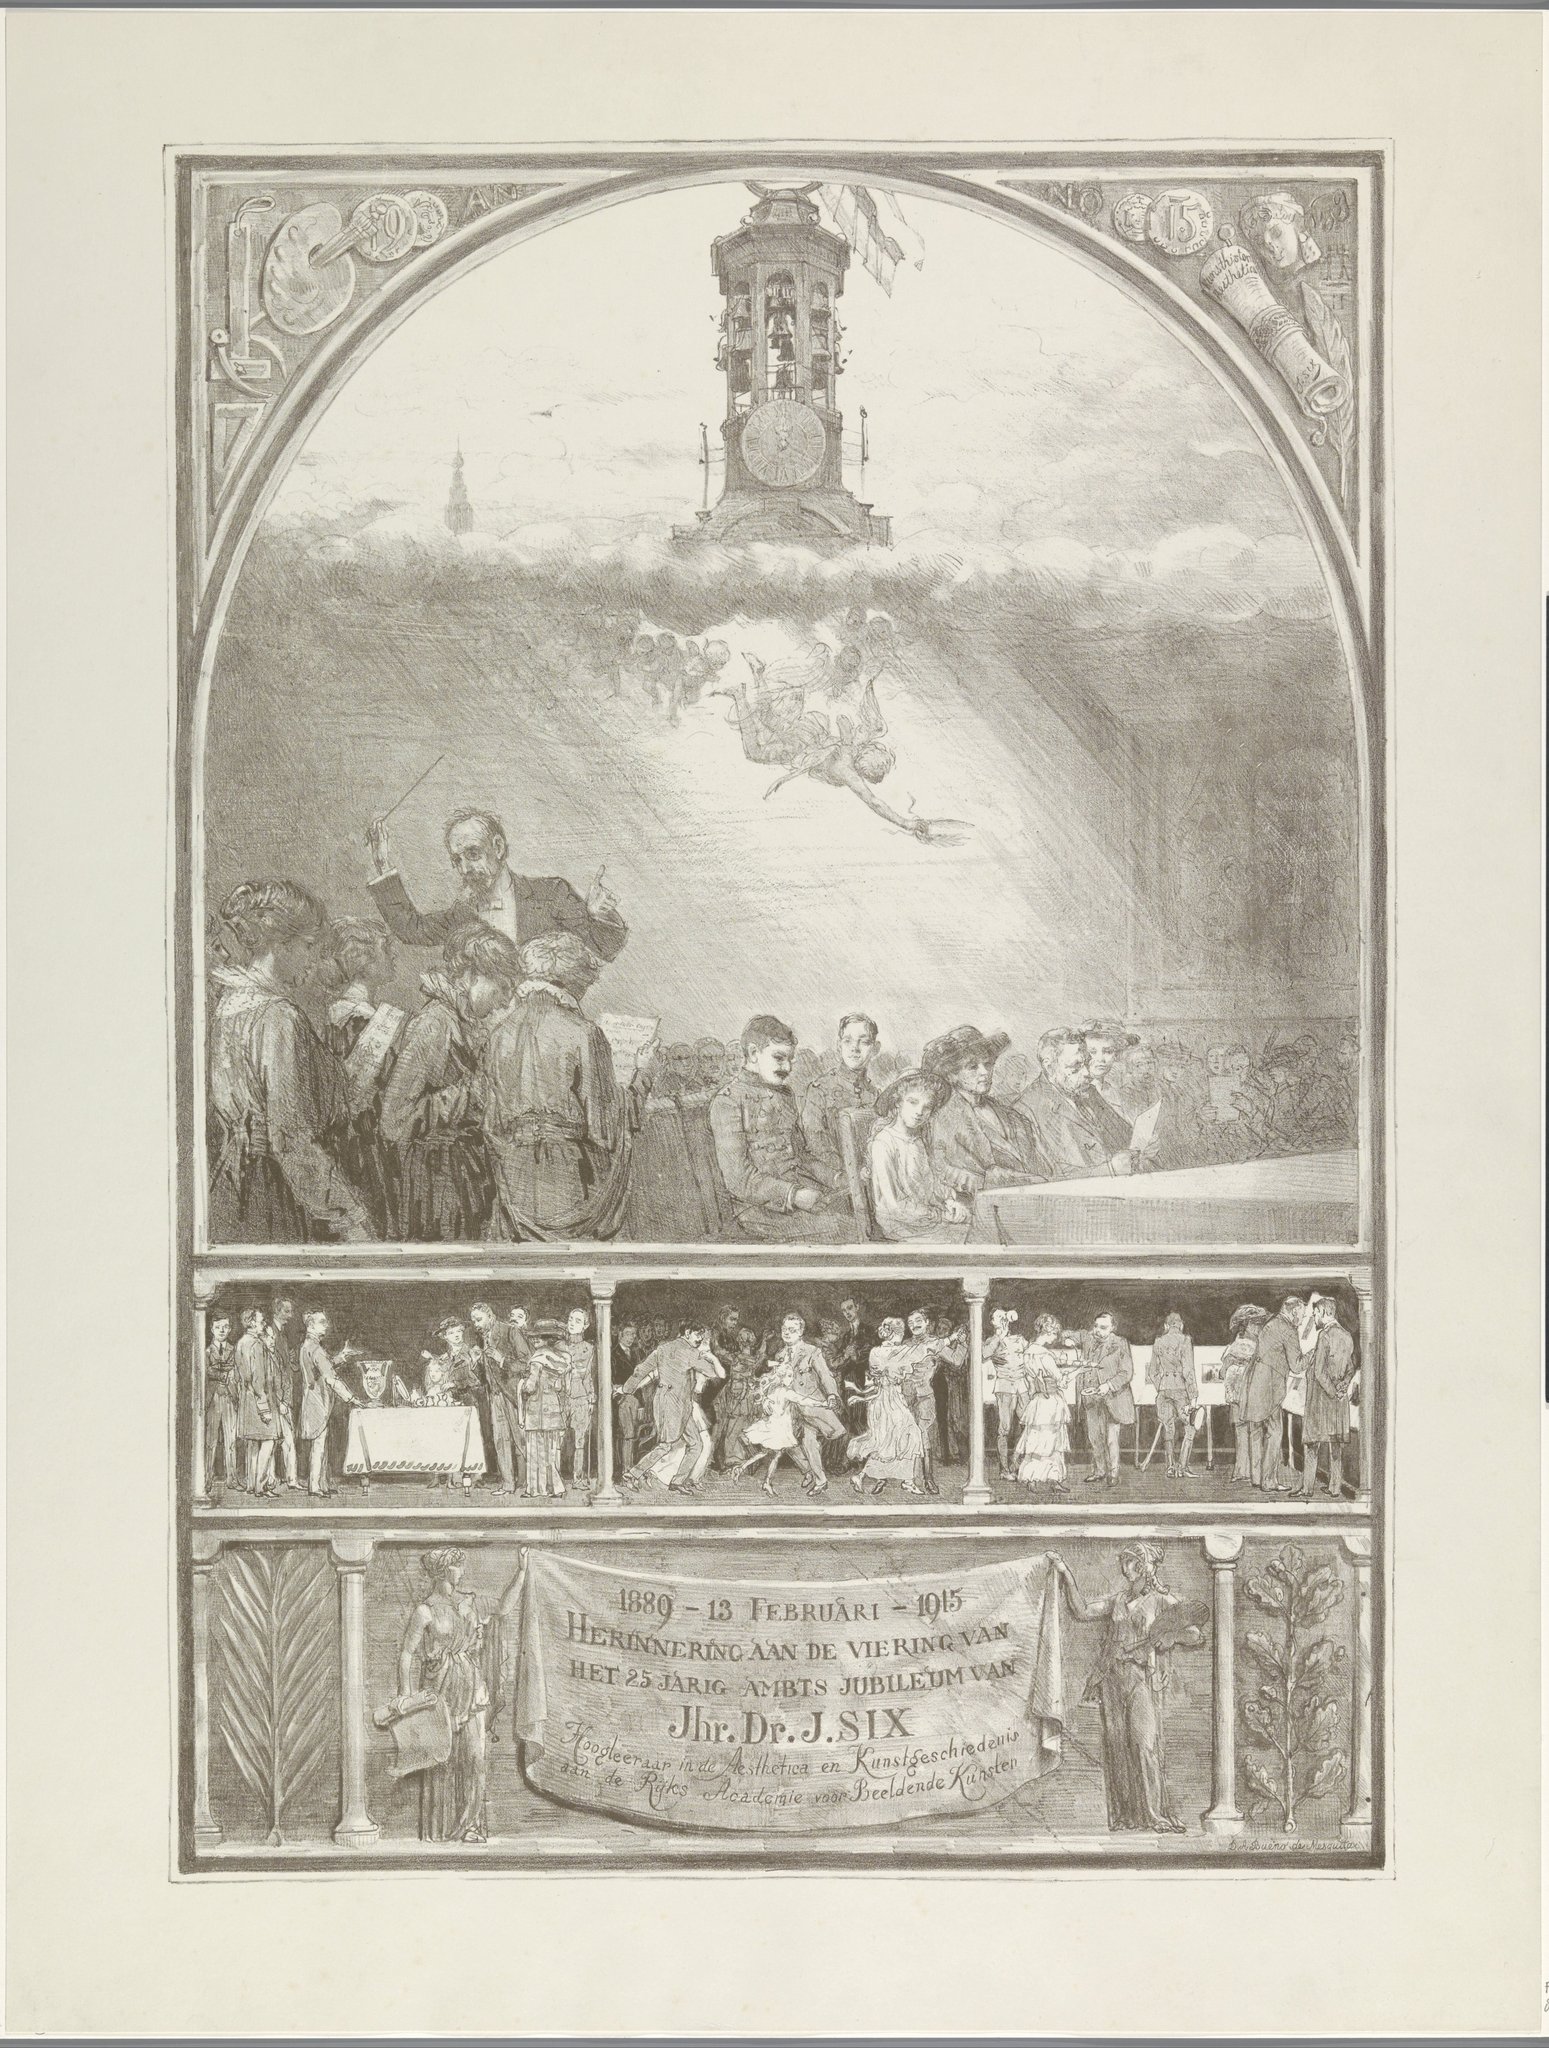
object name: print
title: 1889 - 13 Februari - 1915 / Herinnering aan de viering van het 25 jarig ambts jubileum van Jhr Dr. J. Six / Hoogleeraar in de Aesthetica en Kunstgeschiedenis aan de Rijks Academie voor Beeldende Kunsten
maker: david bueno de mesquita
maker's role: draughtsman, print maker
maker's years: 1889-1962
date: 1915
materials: paper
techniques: lithograph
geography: netherlands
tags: amsterdam, jonkheer jan six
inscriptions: collector's mark: Lugt 2228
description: Gedenkplaat bij de viering op 13 februari 1915 van het 25-jarig ambtsjubileum van Jhr J. Six als hoogleraar in de Aesthetica en de Kunstgeschiedenis aan de Rijksacademie voor Beeldende Kunsten te Amsterdam. Boven de viering van het jubileum met zang van een koor, wolken met engelen en een Amsterdamse toren. Daaronder een fries met drie scènes van de feestelijkheden.